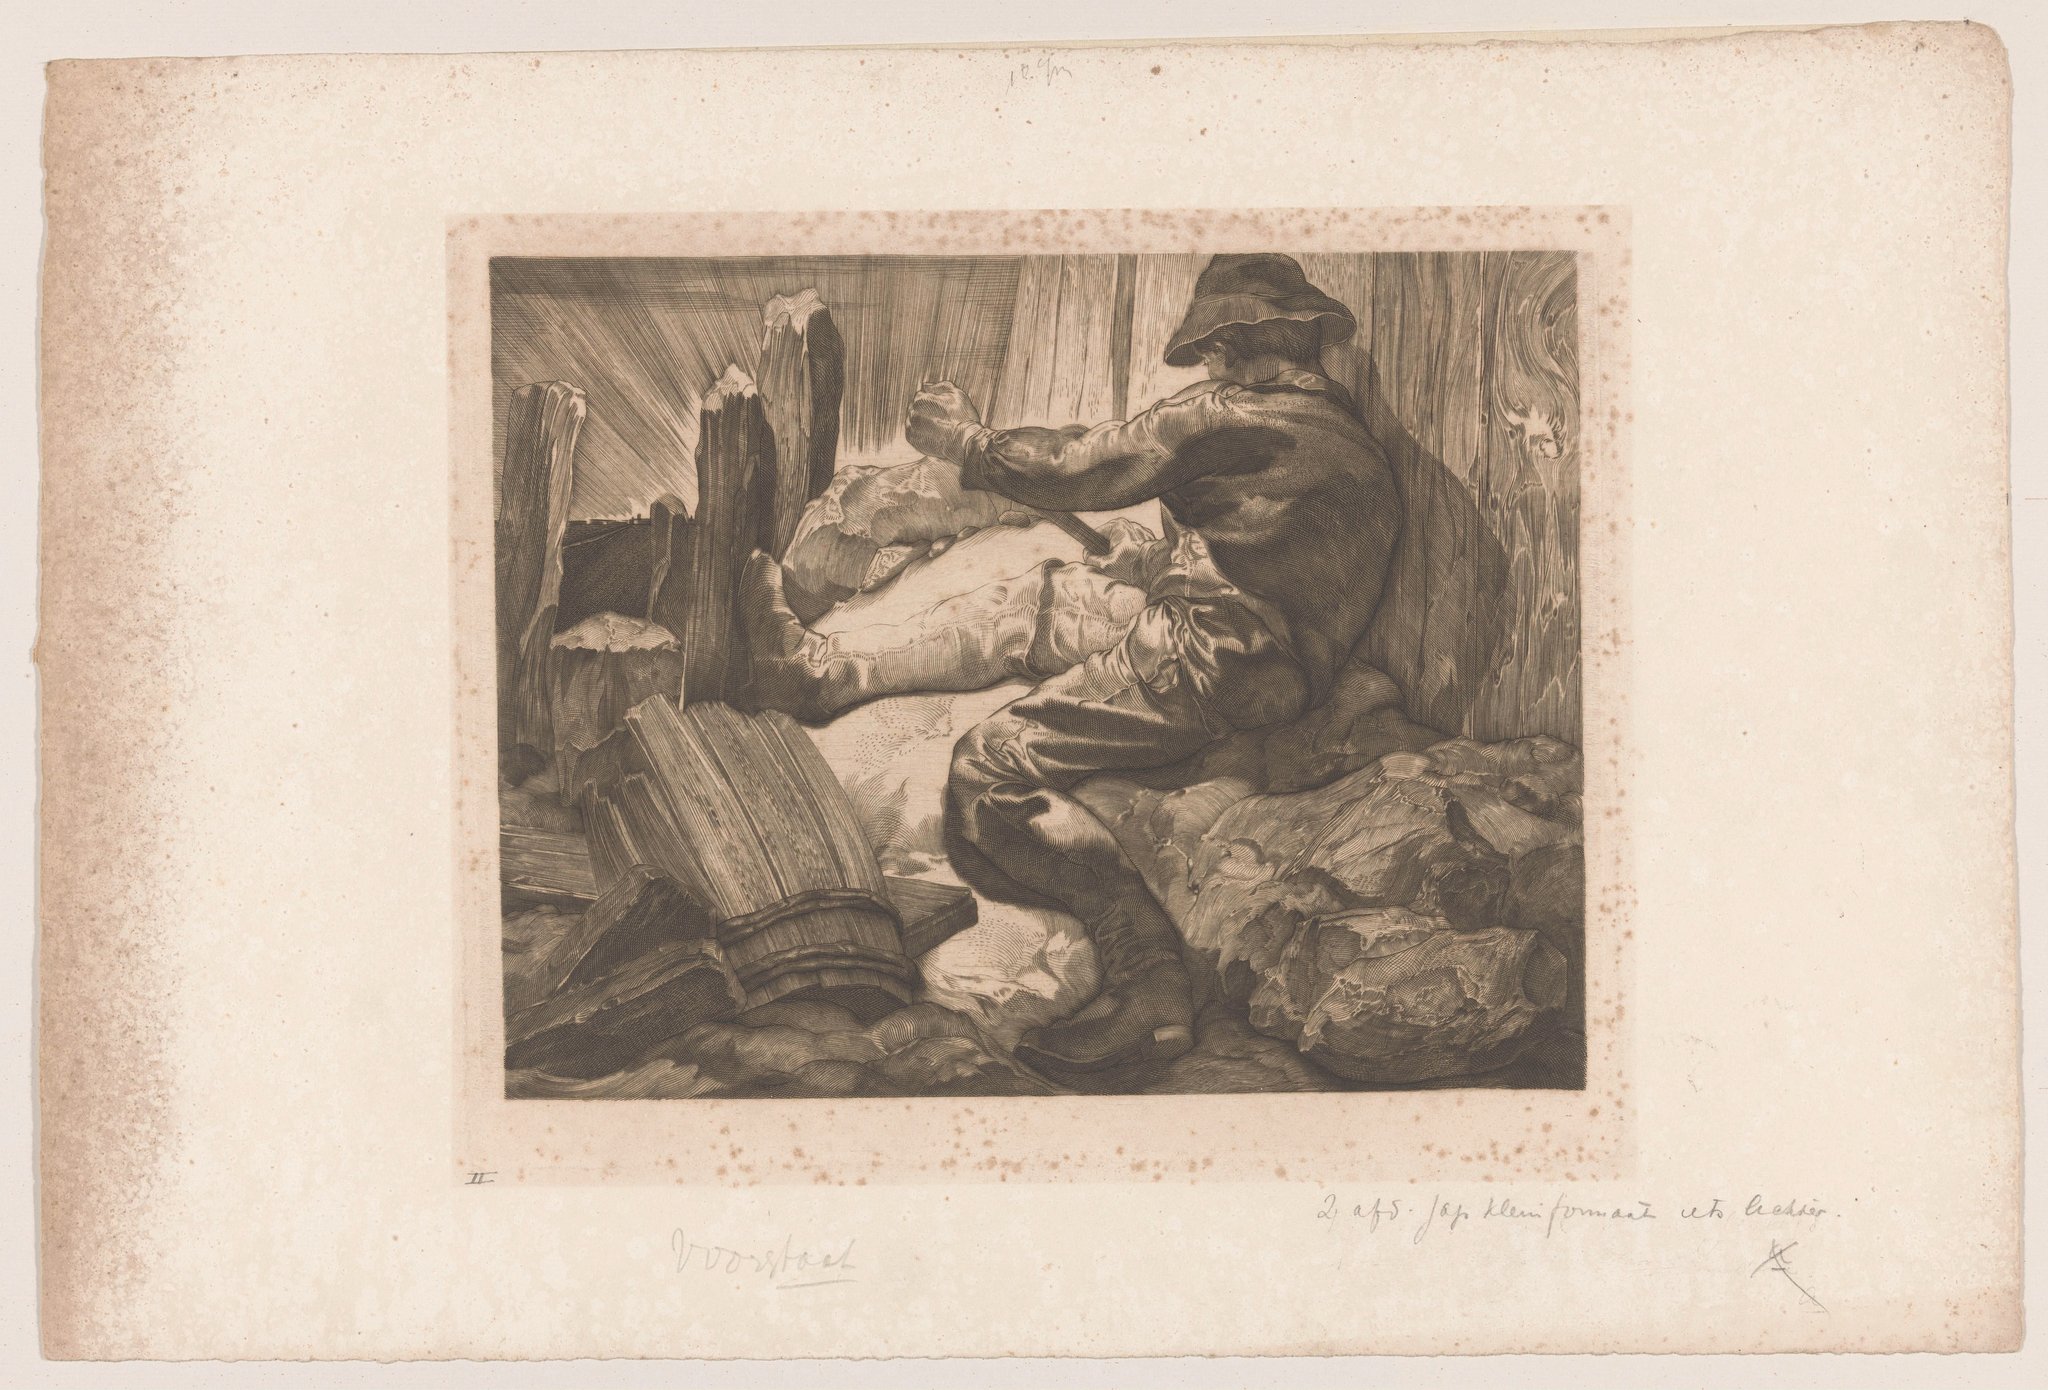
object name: print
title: Grondwerker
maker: johannes josephus aarts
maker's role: draughtsman, print maker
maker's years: 1871-1934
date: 1881-1934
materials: paper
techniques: engraving, intaglio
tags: working class, labourers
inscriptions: annotation: ‘Voorstaat. 2 afd. Jap. klein formaat, iets lichter.’, collector's mark: Lugt 2166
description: Een man in werkkleding met hoed wrikt met een staaf tussen houten planken die samen een muur vormen. Links op de voorgrond een kapotte houten ton.